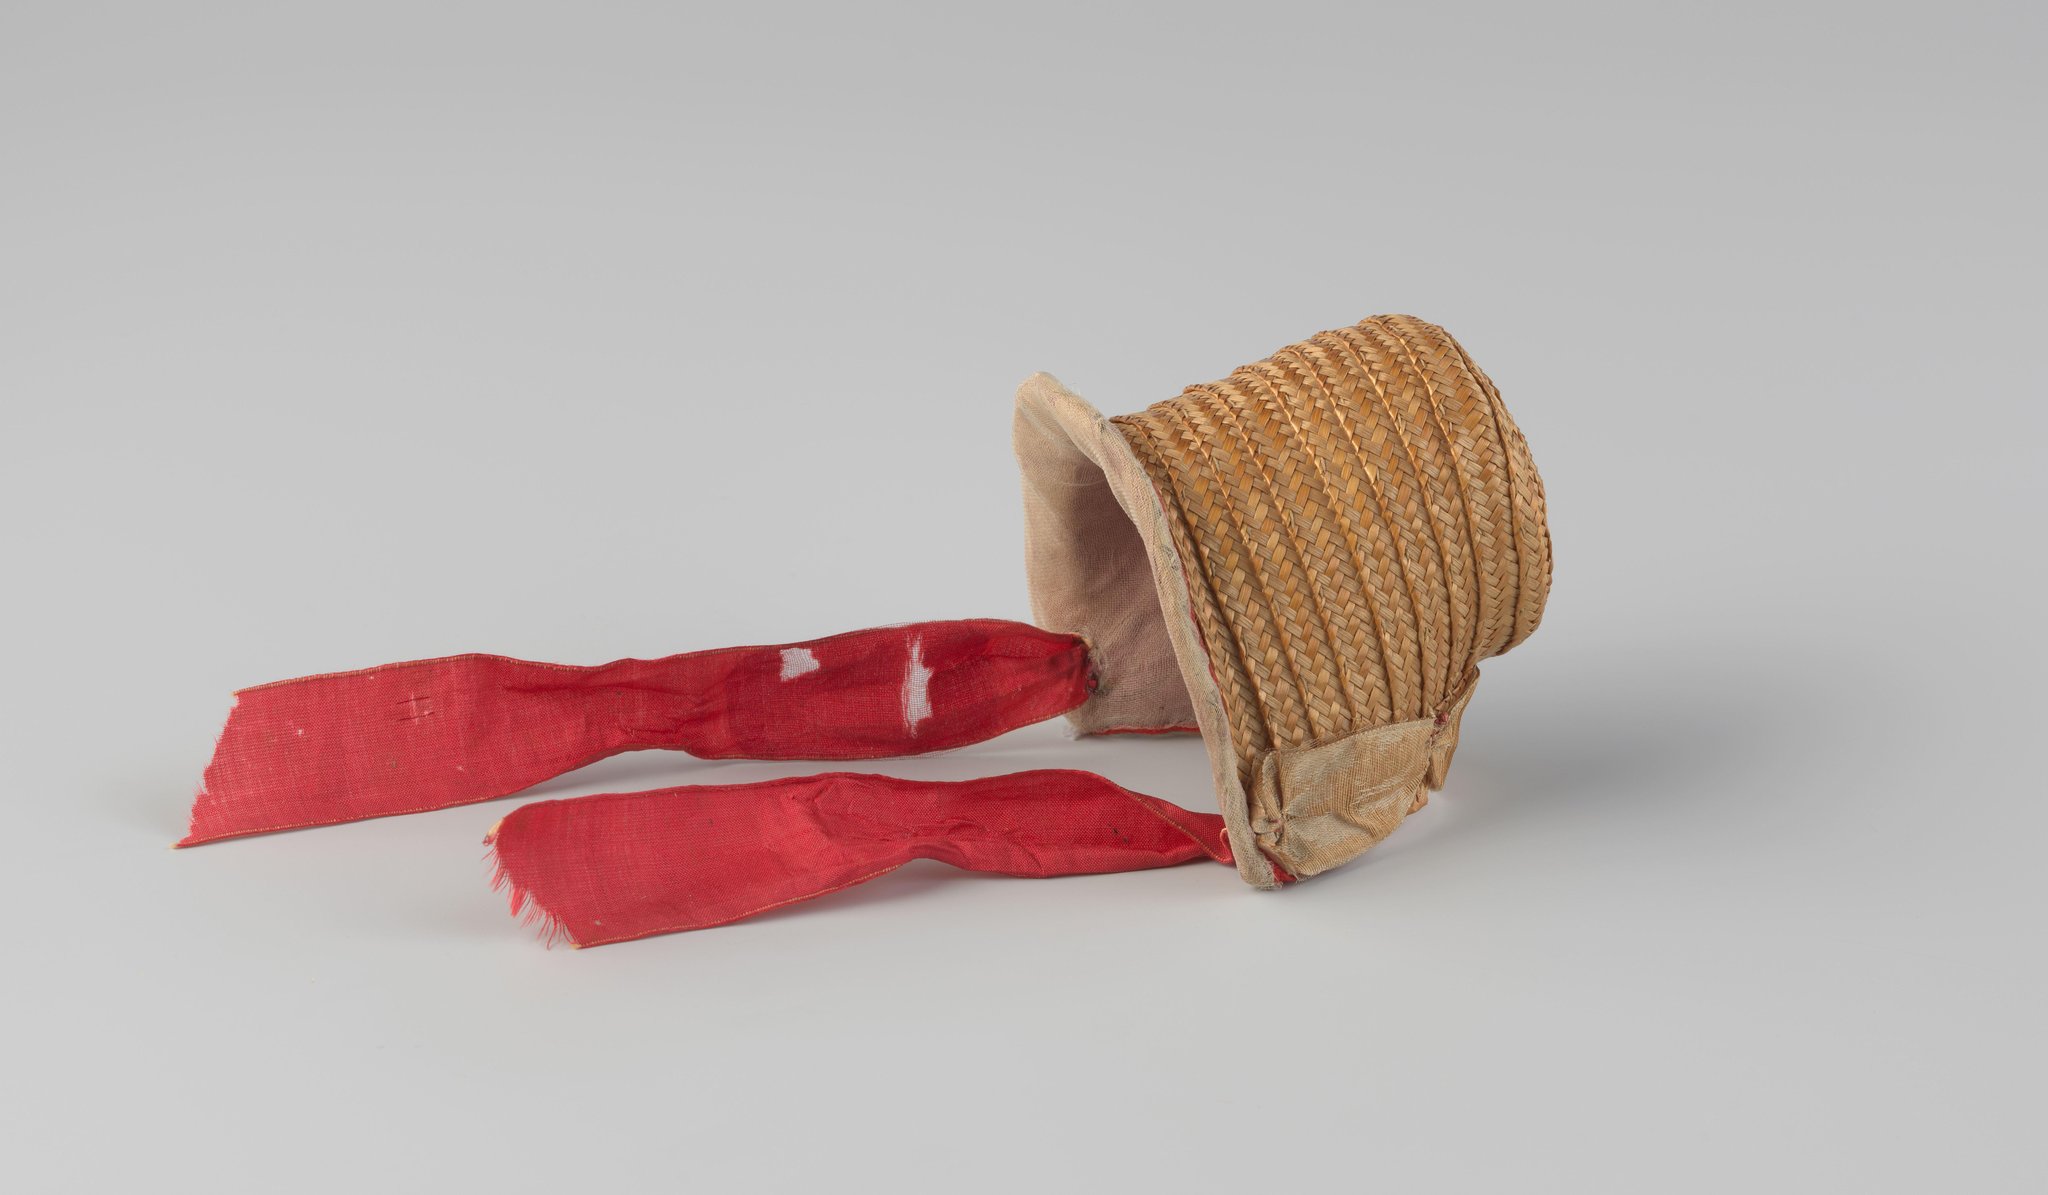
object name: bonnet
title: Luifelhoed van stro, gevoerd met rozerode zijde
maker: Anonymous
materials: silk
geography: netherlands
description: Luifelhoed van geel stro, gevoerd met rose-rode zij.